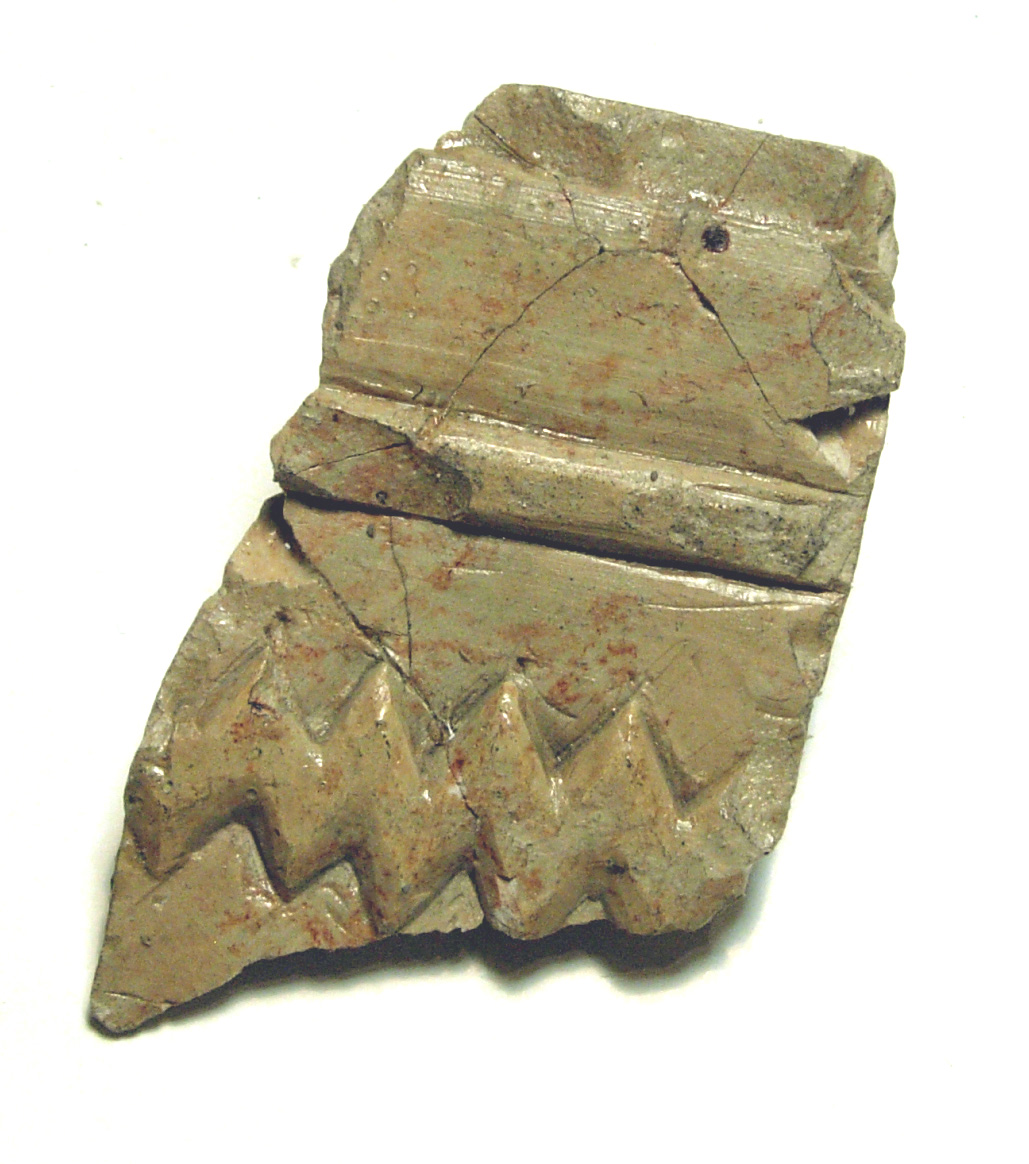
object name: relief, tomb of nespekashuty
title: Raised relief fragment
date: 664-610 BCE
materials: limestone, varnish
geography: egypt